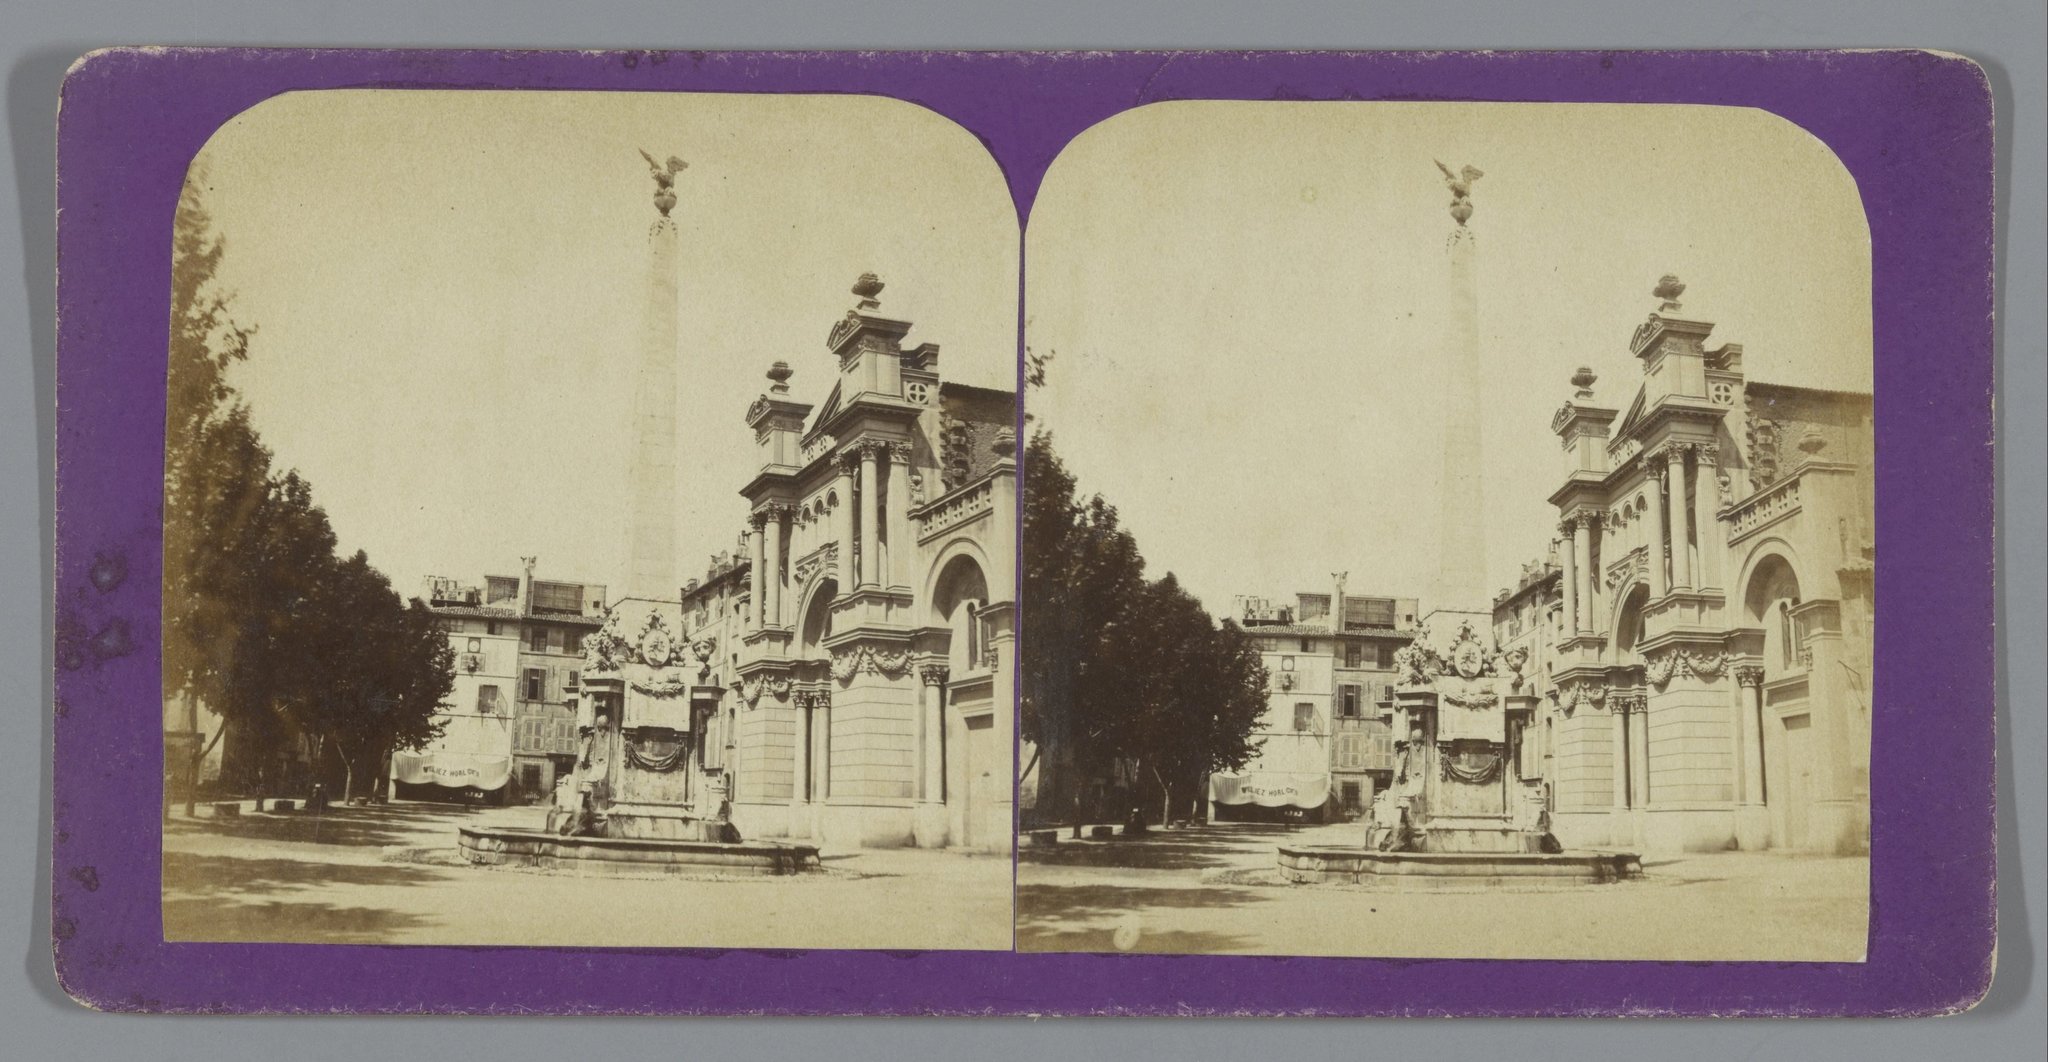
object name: stereograph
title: Gezicht op het Place des Prêcheurs te Aix-en-Provence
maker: jean andrieu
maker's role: fotograaf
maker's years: 1816-1872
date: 1862-1876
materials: cardboard, photographic support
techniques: albumen print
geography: aix-en-provence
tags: column, pillar ~ architecture, village square, place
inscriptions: inscription: ‘Place du Palais a Aix’, number: ‘617’